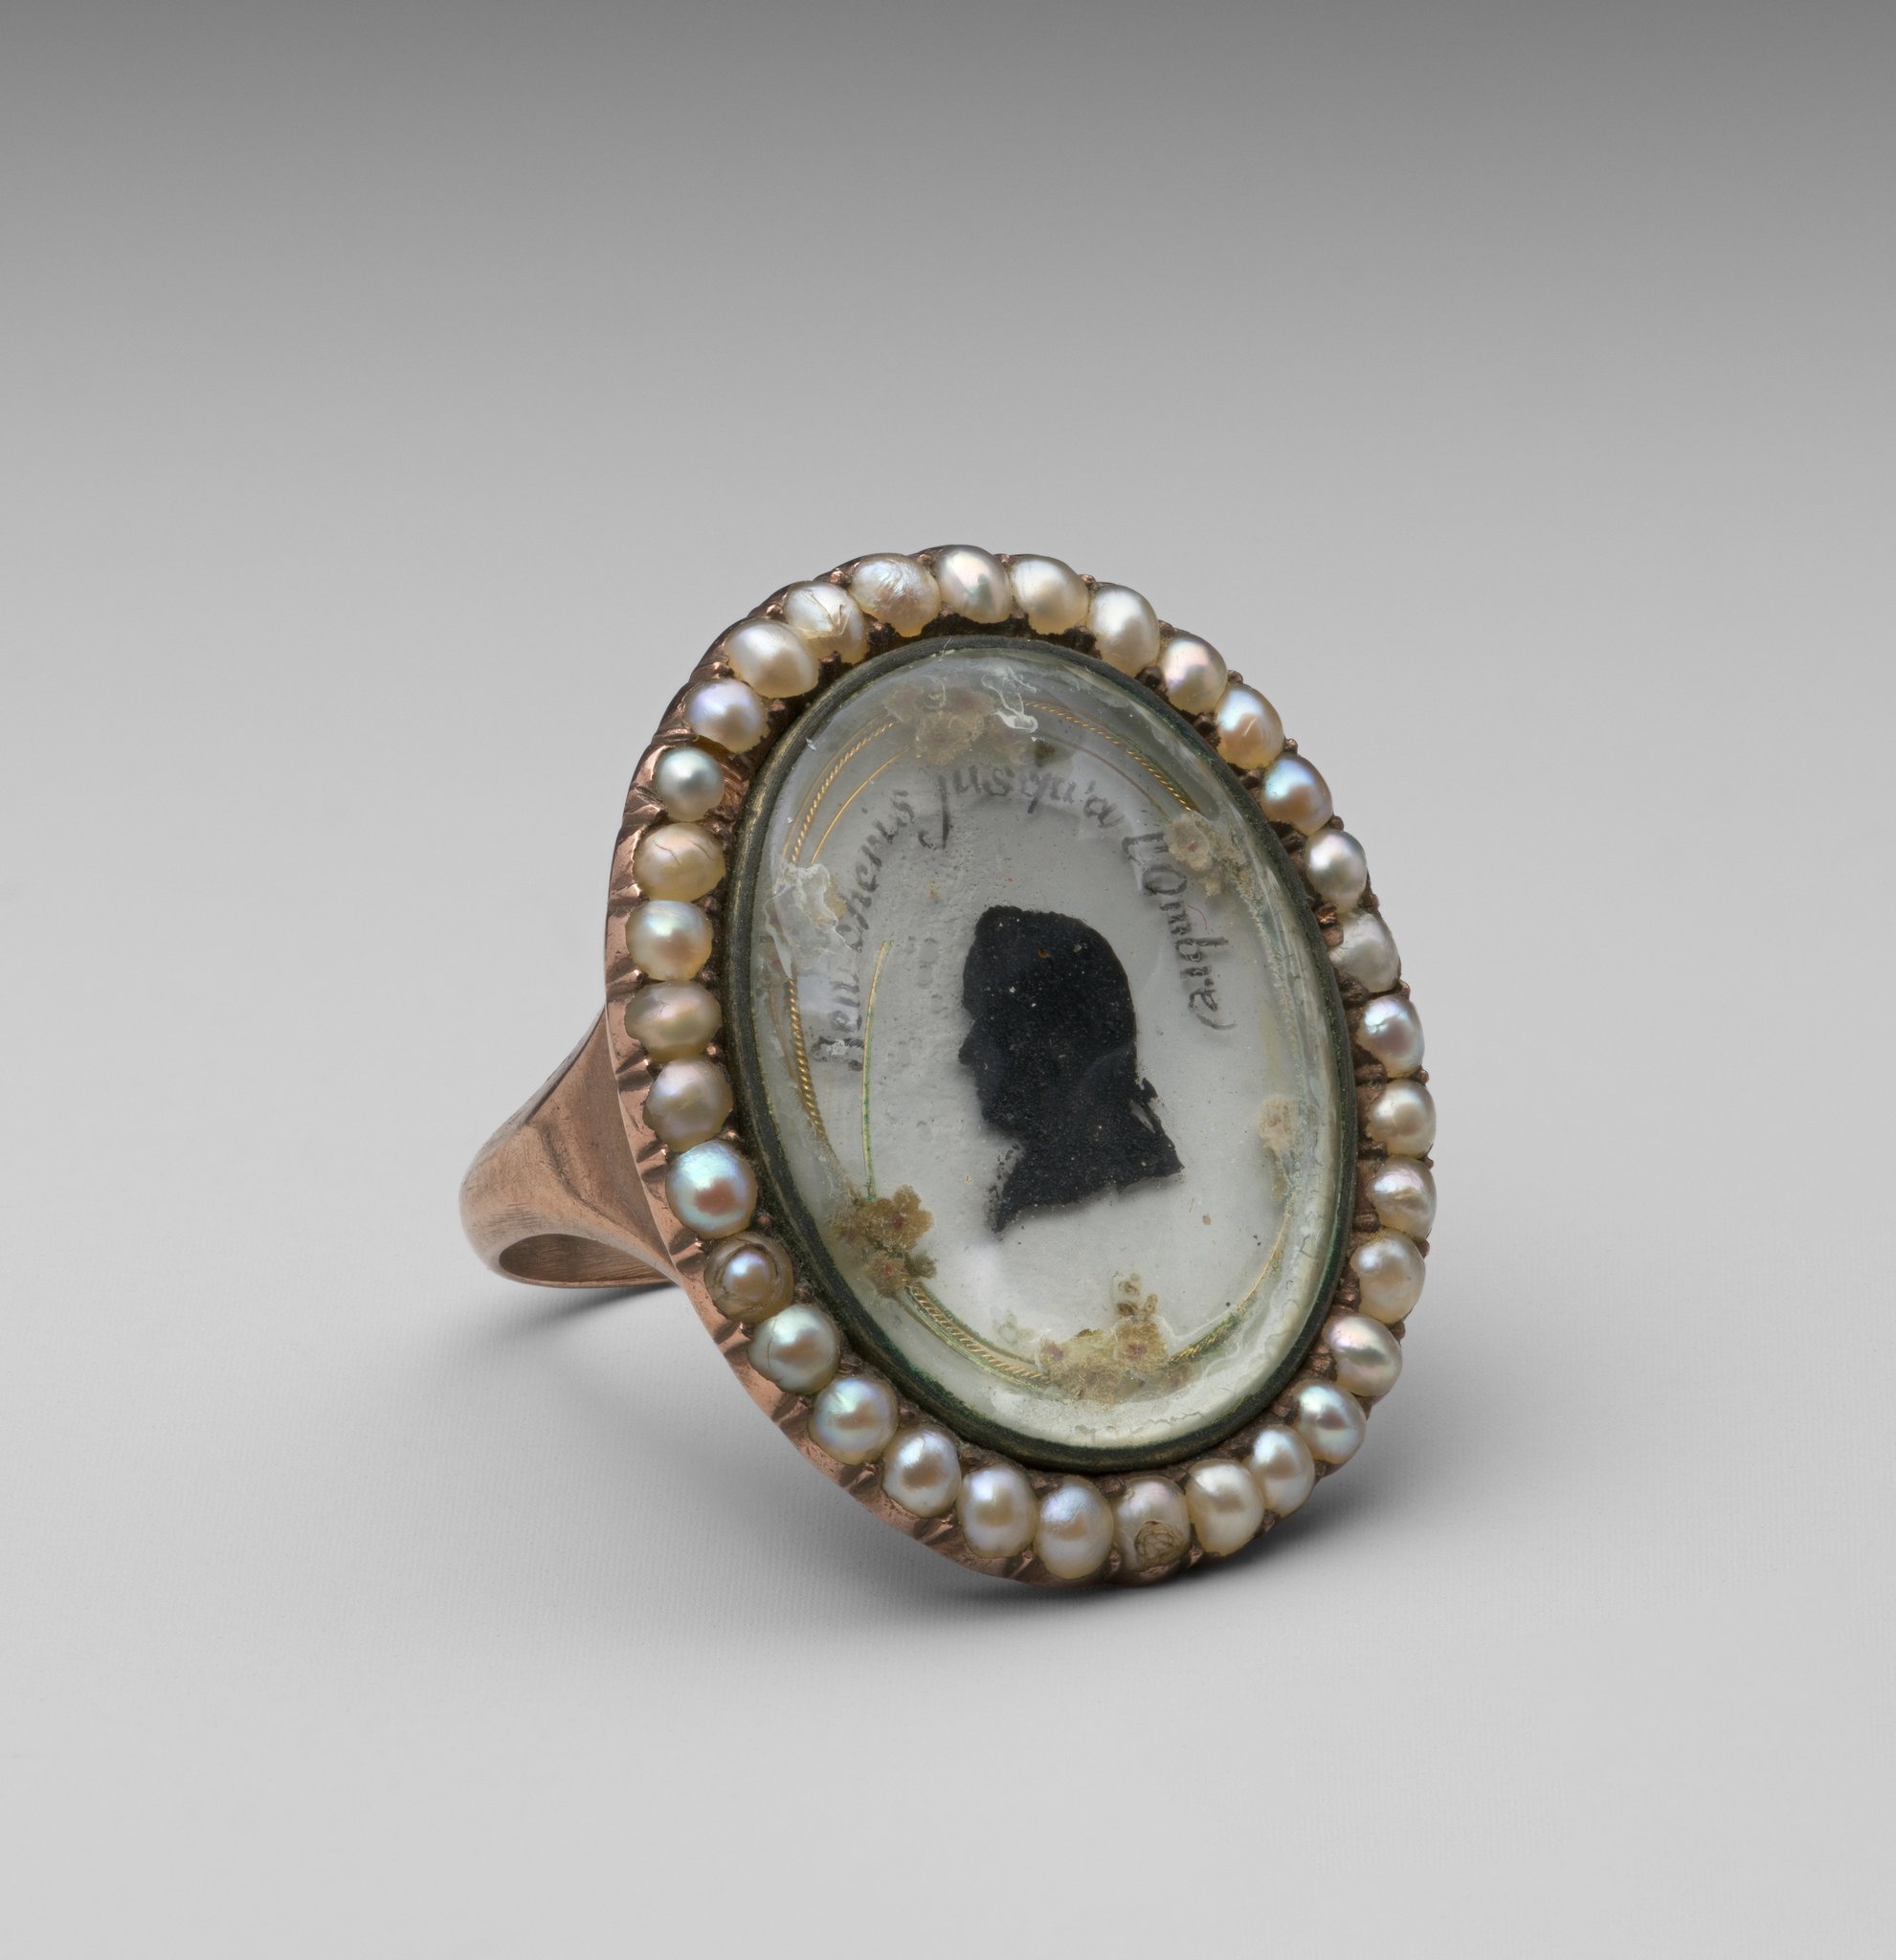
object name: ring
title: Memorial ring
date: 1767-1800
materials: gold, pearl